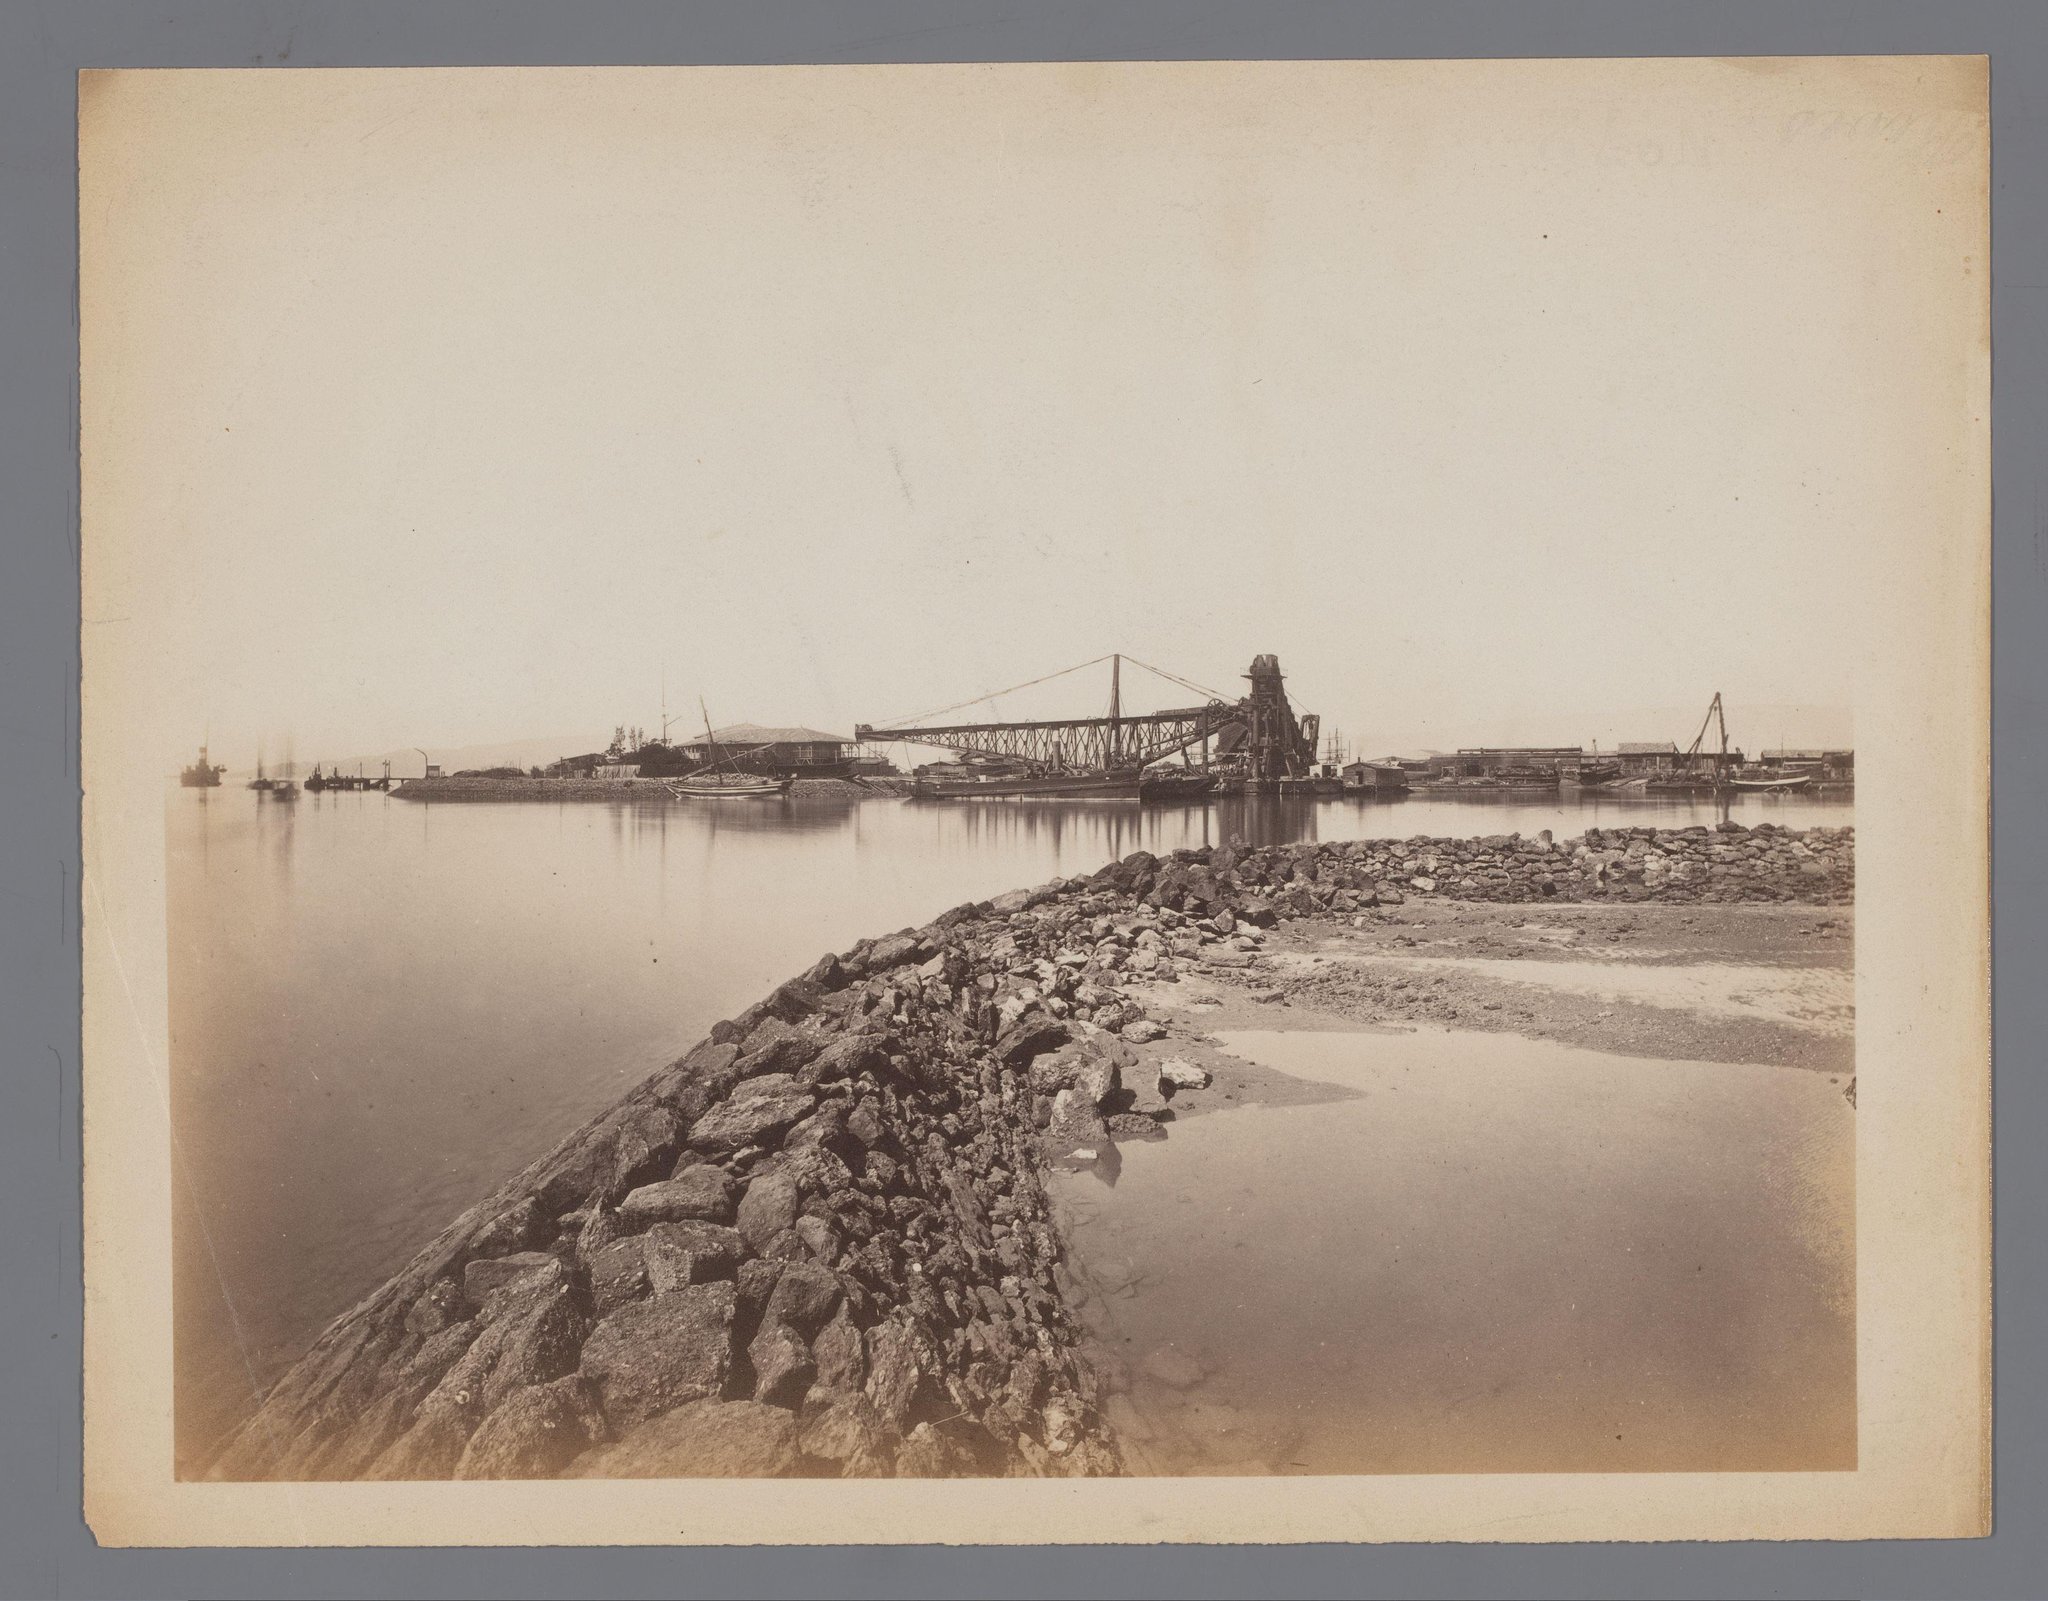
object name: photograph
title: Gezicht op een haven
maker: Anonymous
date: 1860-1900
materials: paper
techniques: albumen print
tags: harbour